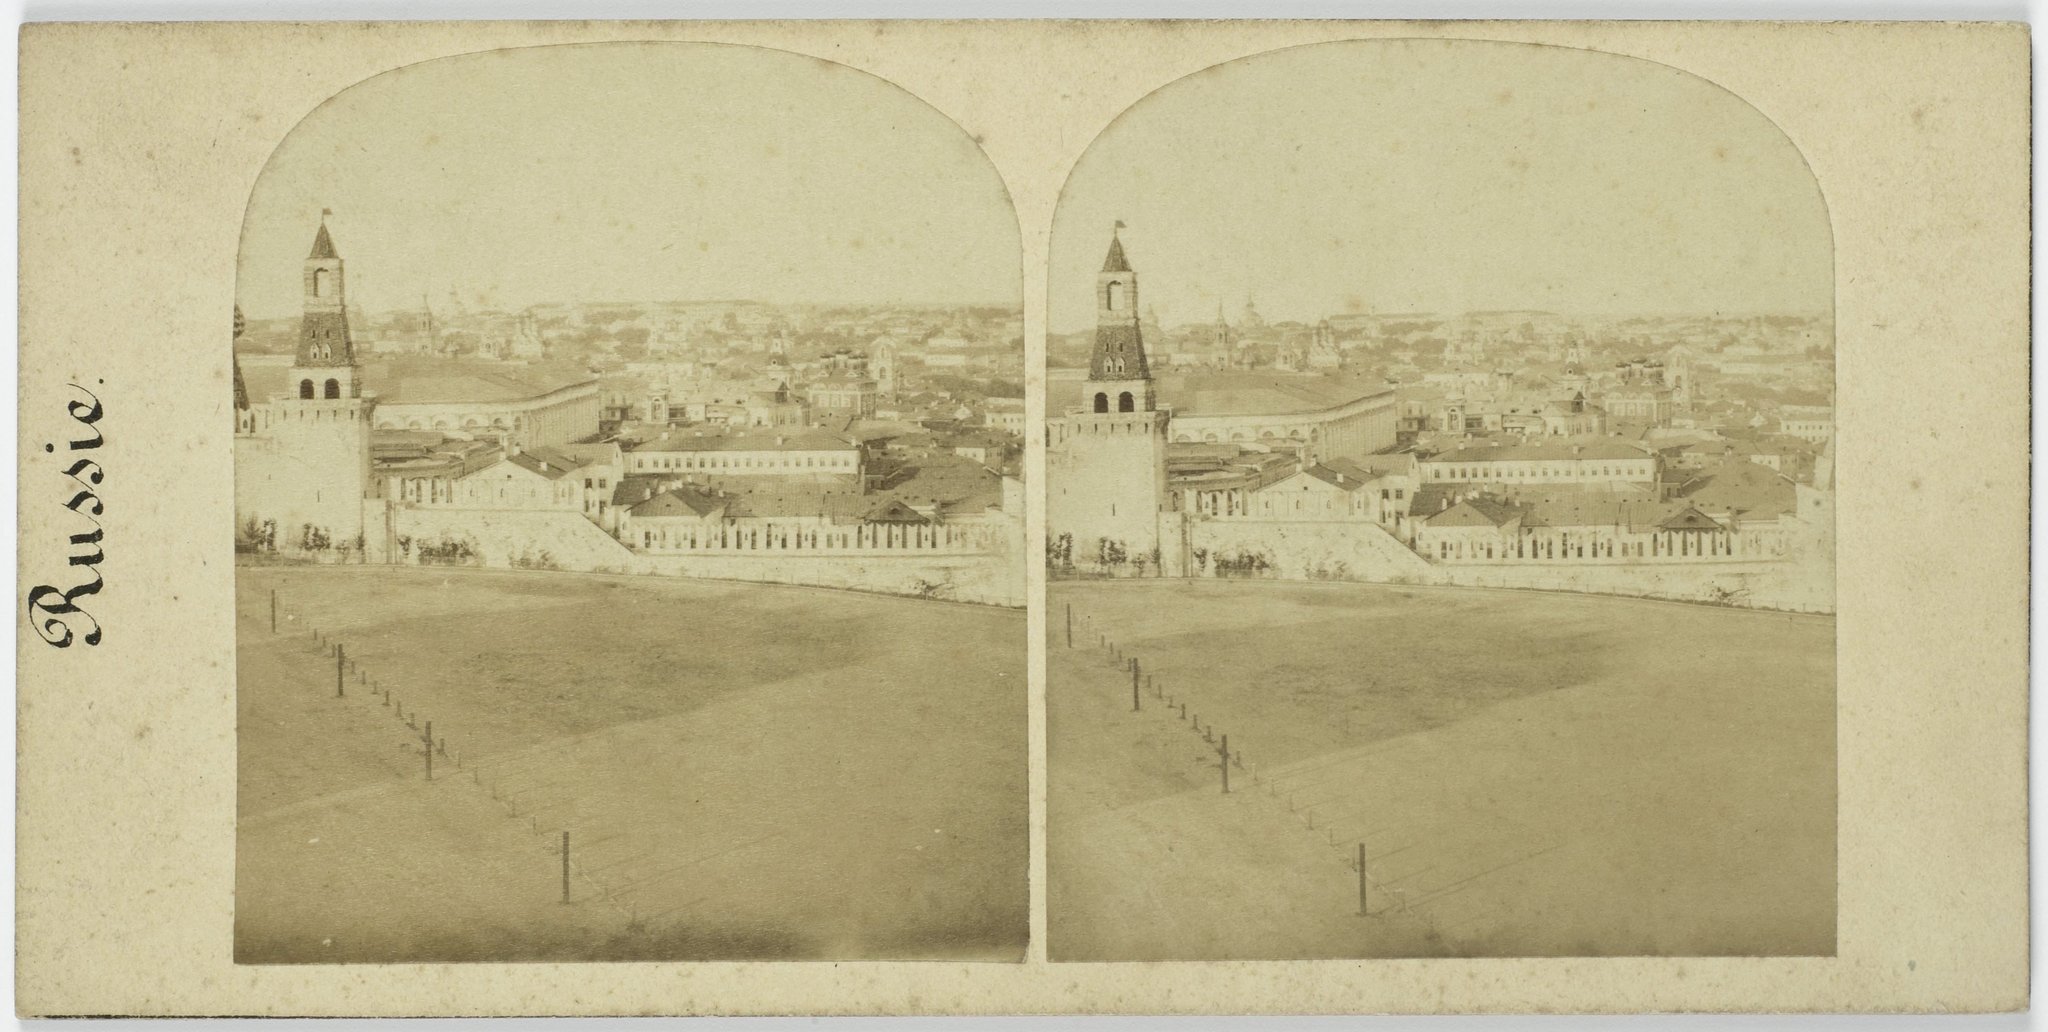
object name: stereograph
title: Russie.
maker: Anonymous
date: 1850-1880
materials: cardboard, photographic support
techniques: albumen print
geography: kremlin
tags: city-view in general; 'veduta'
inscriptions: inscription: ‘Panorama de Moscou pris du Kremlin’, inscription: ‘VOYAGE EN RUSSIE.’, number: ‘No 45’